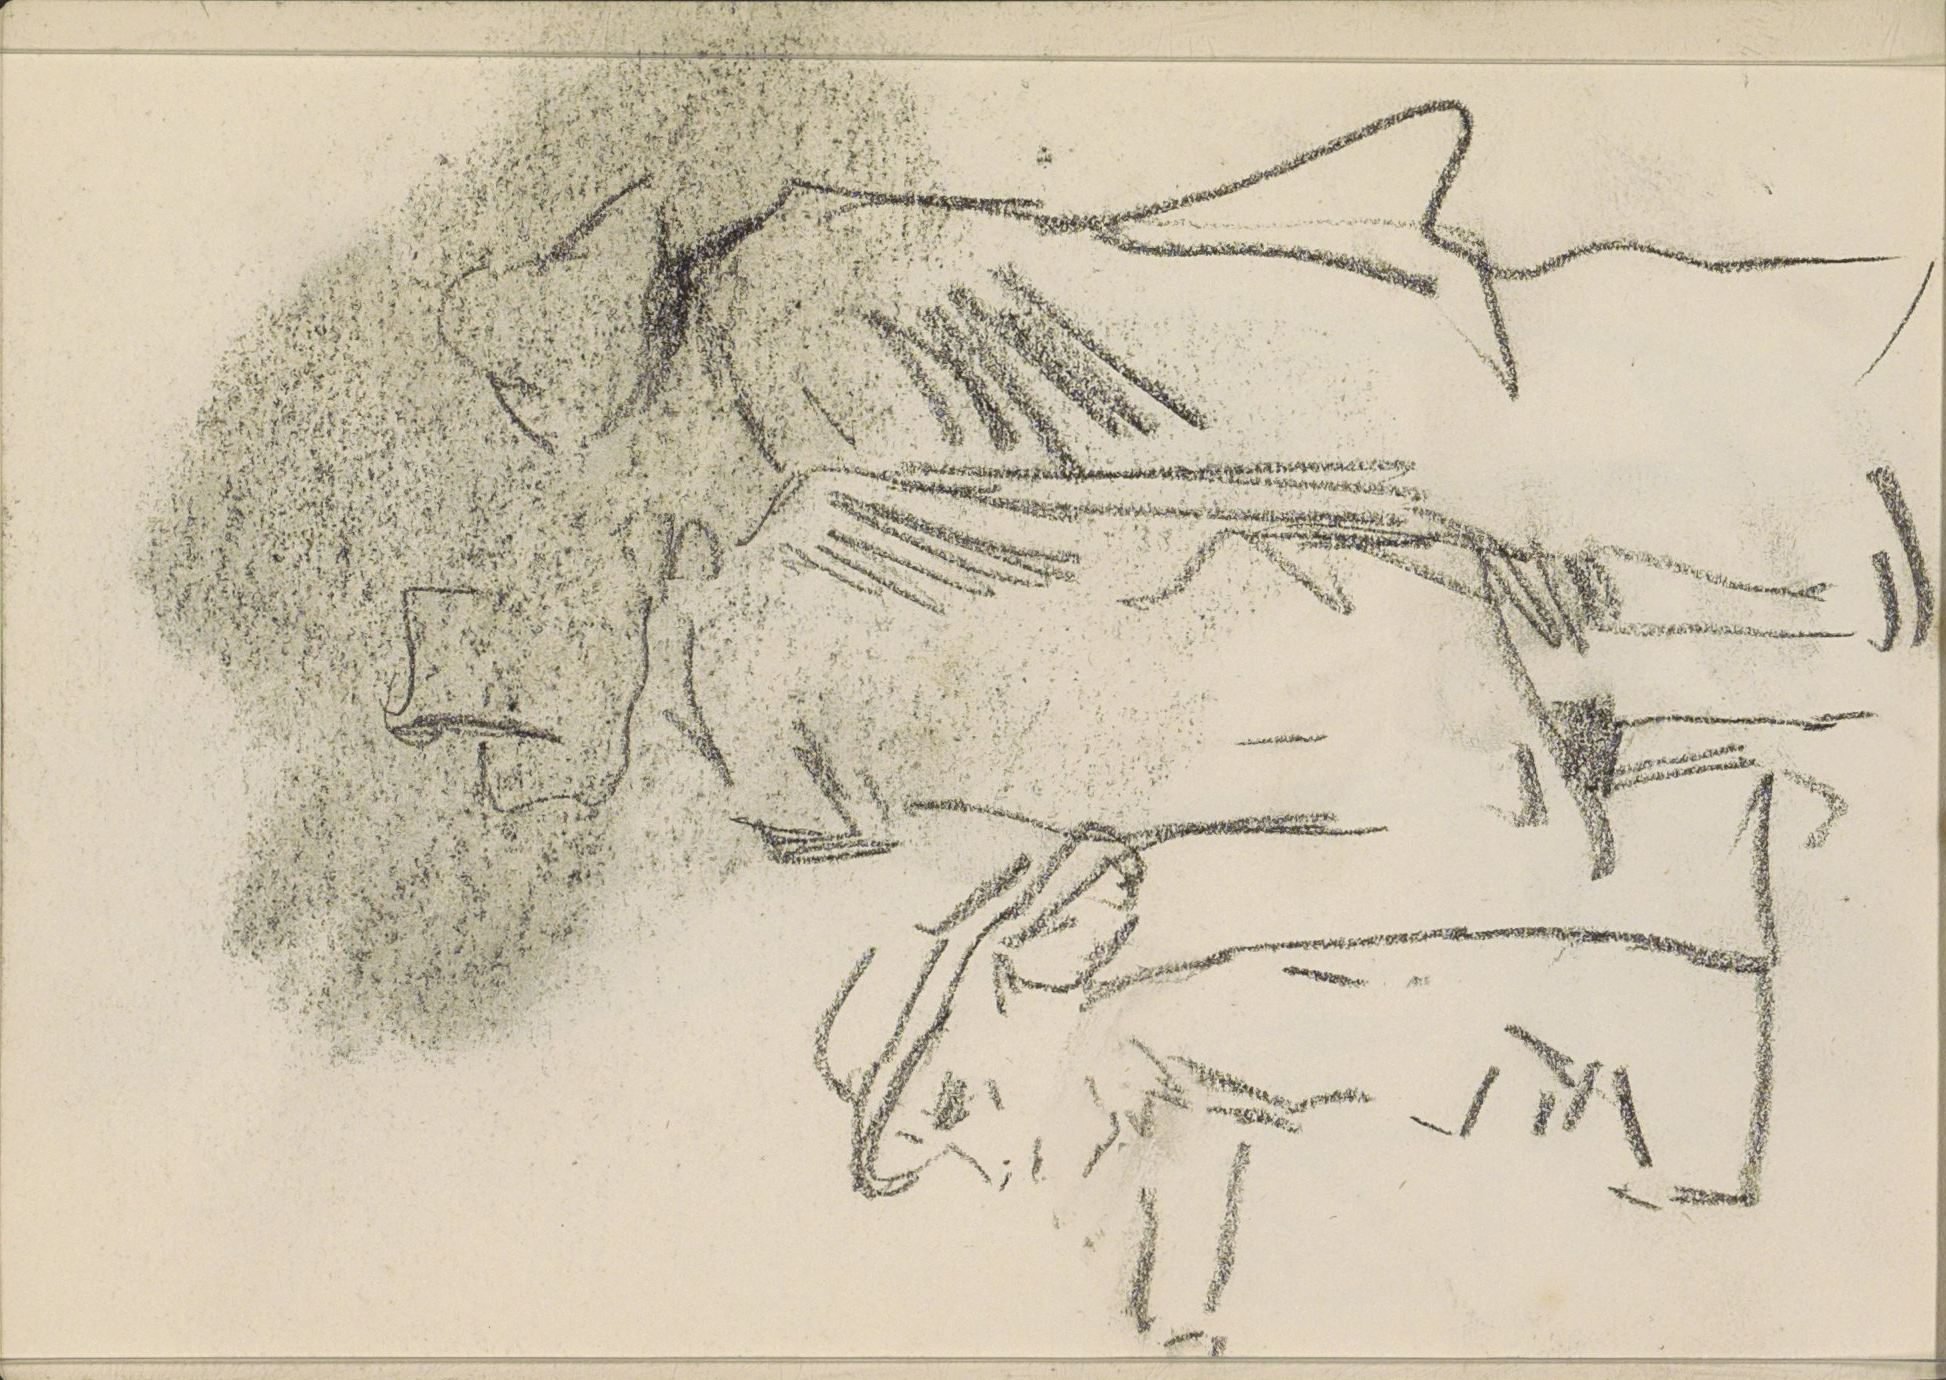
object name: sketchbook leaf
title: Drie figuren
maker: isaac israels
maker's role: draughtsman, painter, print maker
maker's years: 1865-1934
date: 1875-1934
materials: chalk, paper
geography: the hague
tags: the (nude) human figure; 'corpo humano' (ripa) (+ sideview, profile), head-gear: hat, adult man (+ standing), the (nude) human figure; 'corpo humano' (ripa) (+ back view)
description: Twee staande figuren met hoeden, op de rug gezien. Links een figuur met hoed, in profiel. Pagina 4 uit schetsboek XLII met 32 pagina's.